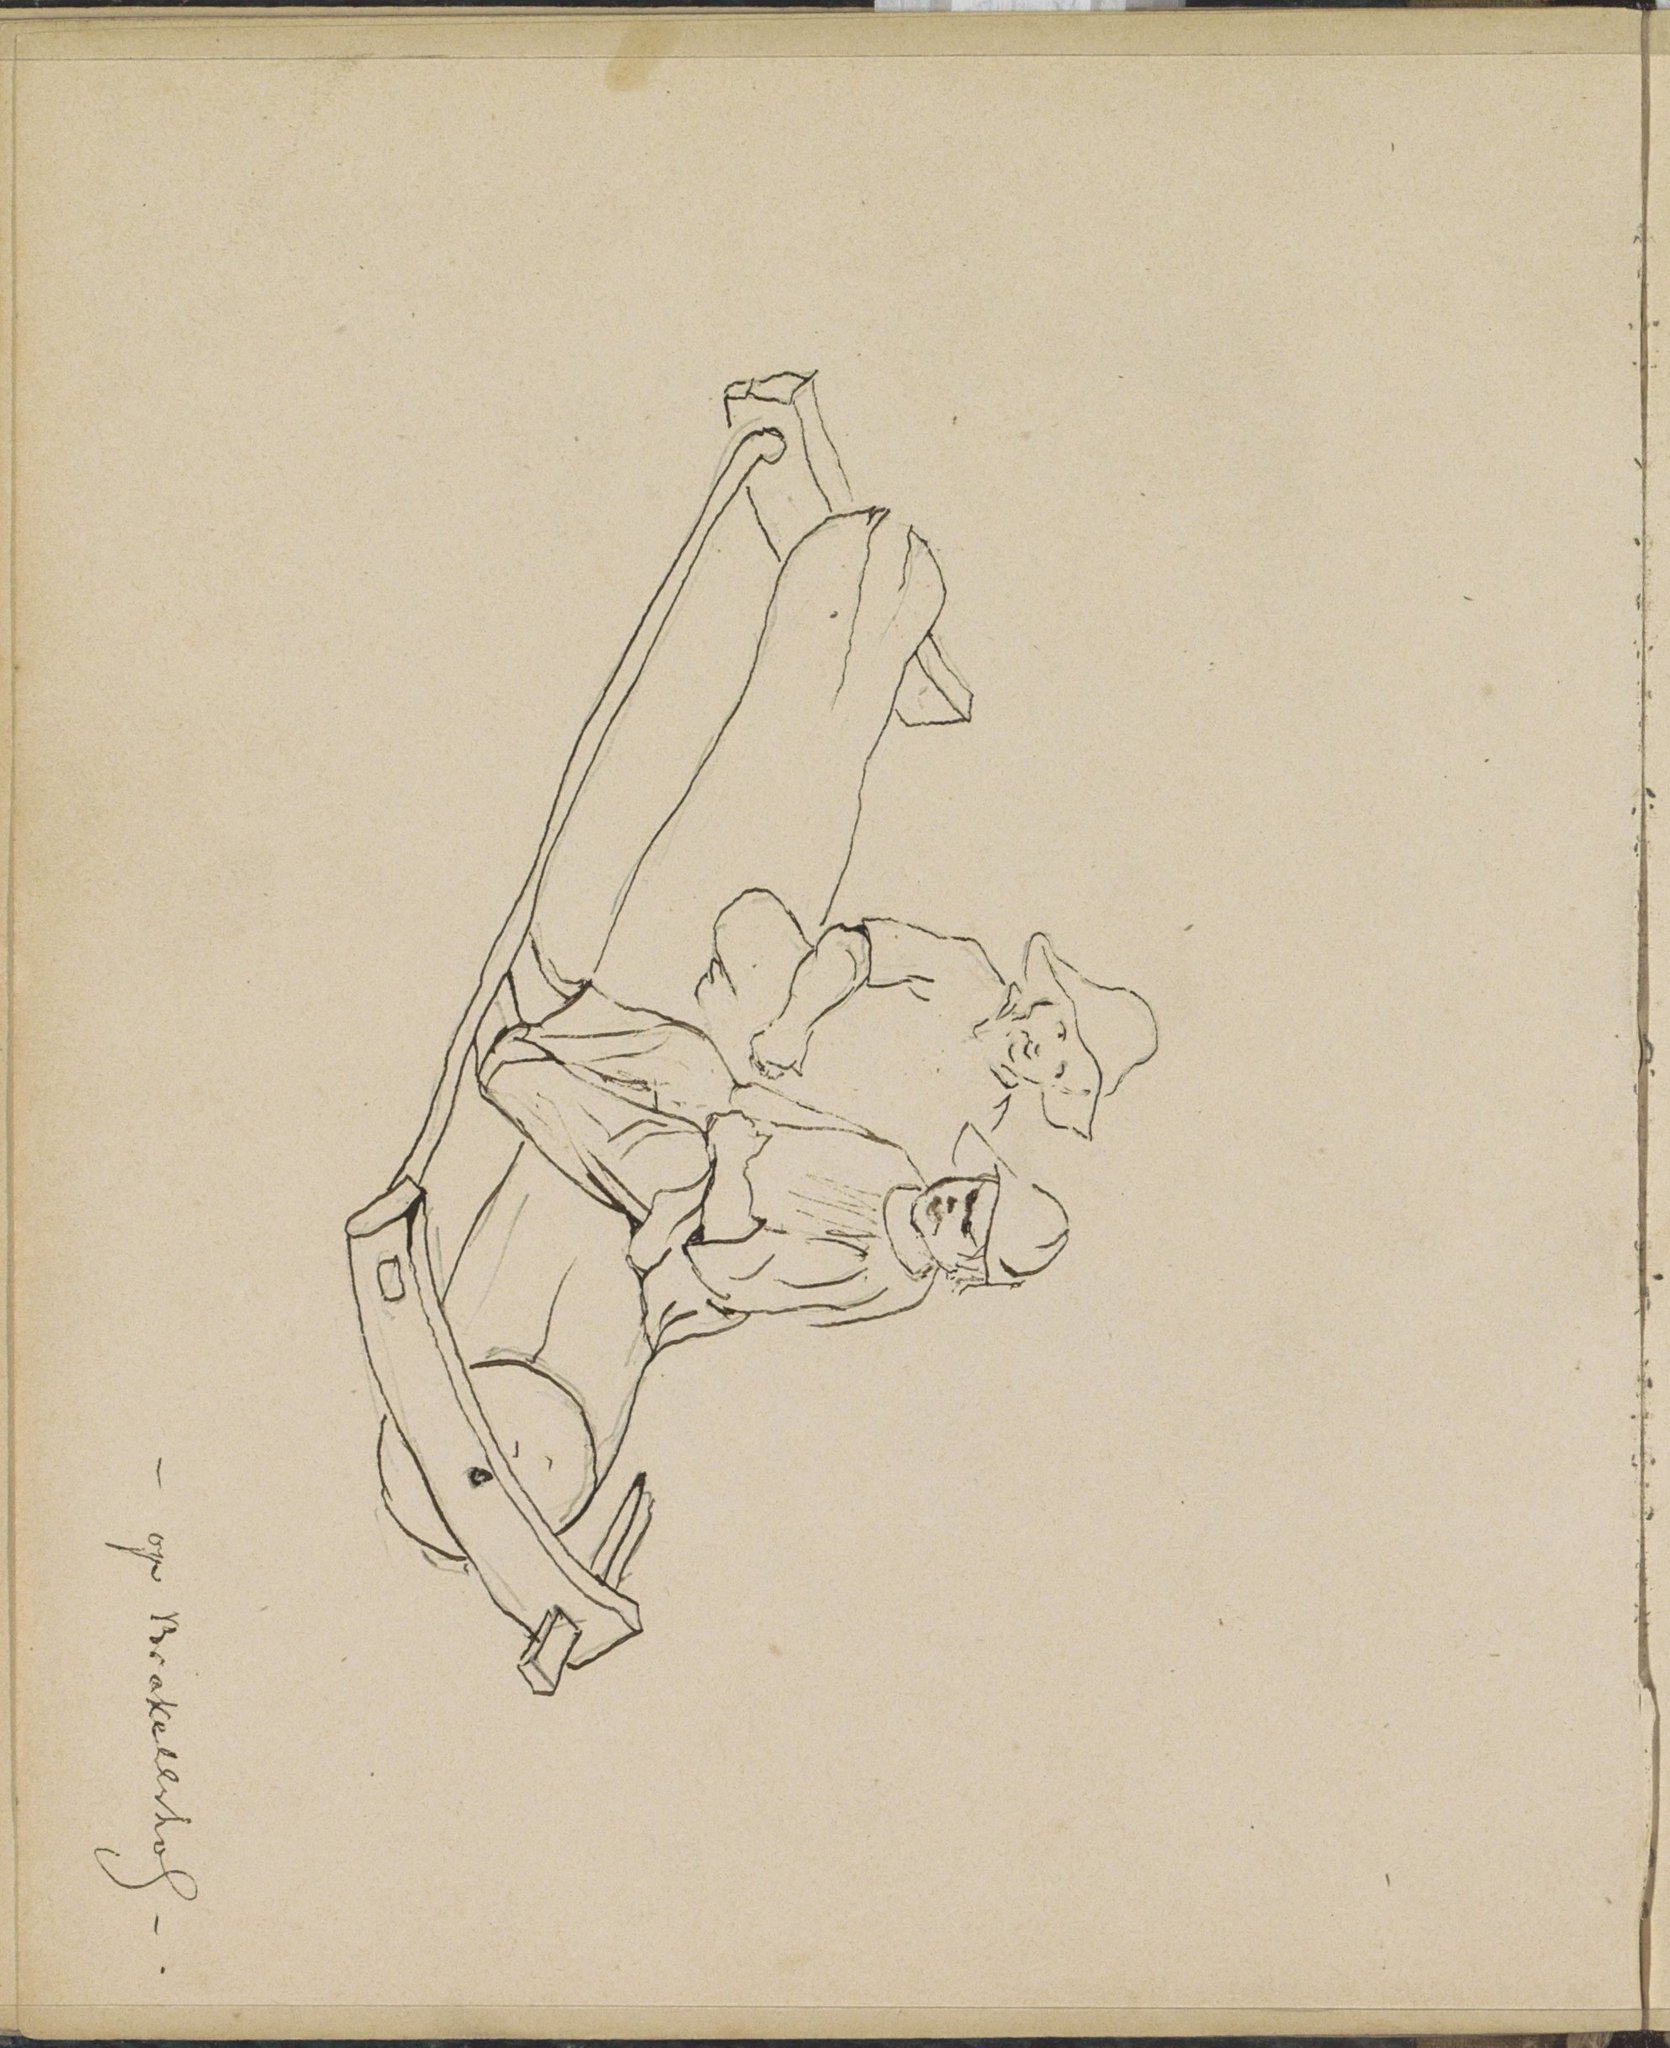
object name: sketchbook leaf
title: Twee kinderen zittend op een boomstam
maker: johannes tavenraat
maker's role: draughtsman, painter, print maker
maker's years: 1809-1881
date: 1841-1853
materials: ink, paper, pencil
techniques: pen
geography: materborn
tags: trees, sitting figure, child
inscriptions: annotation: ‘- op Brakelerhof -’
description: Blad 69 verso uit een schetsboek met 87 bladen.